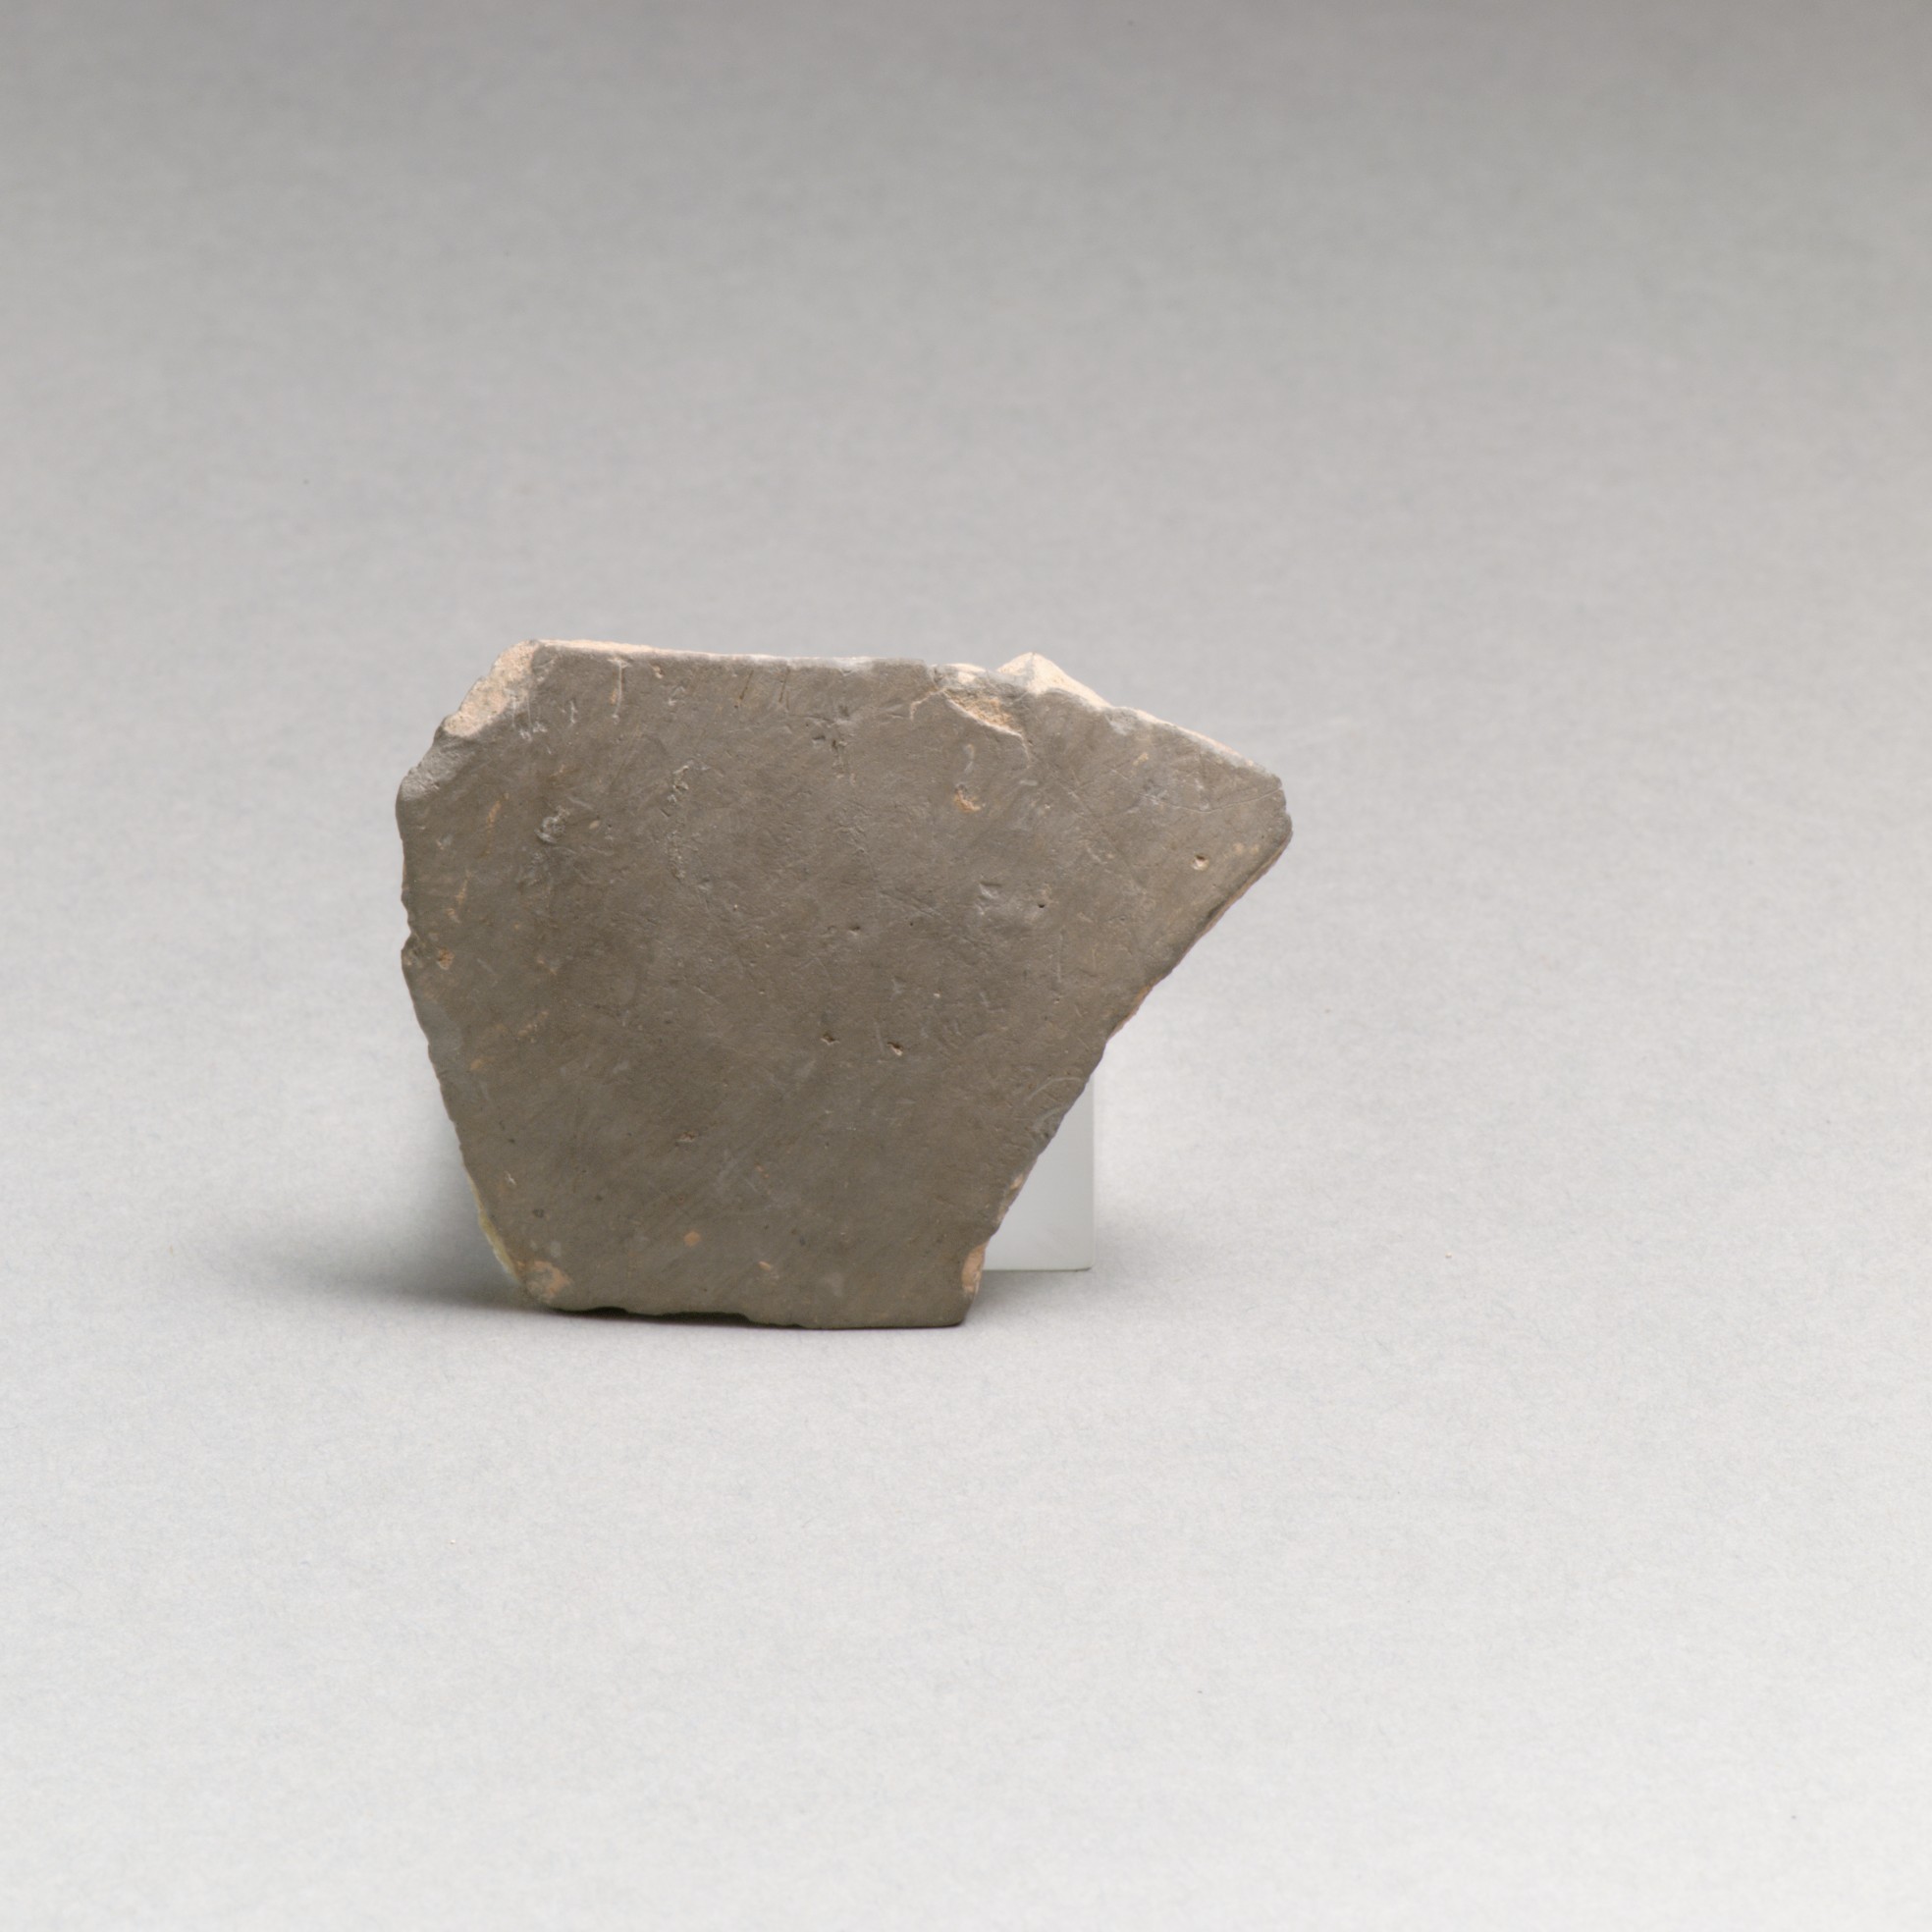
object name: vase fragment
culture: minoan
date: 2600-2000 BCE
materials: terracotta